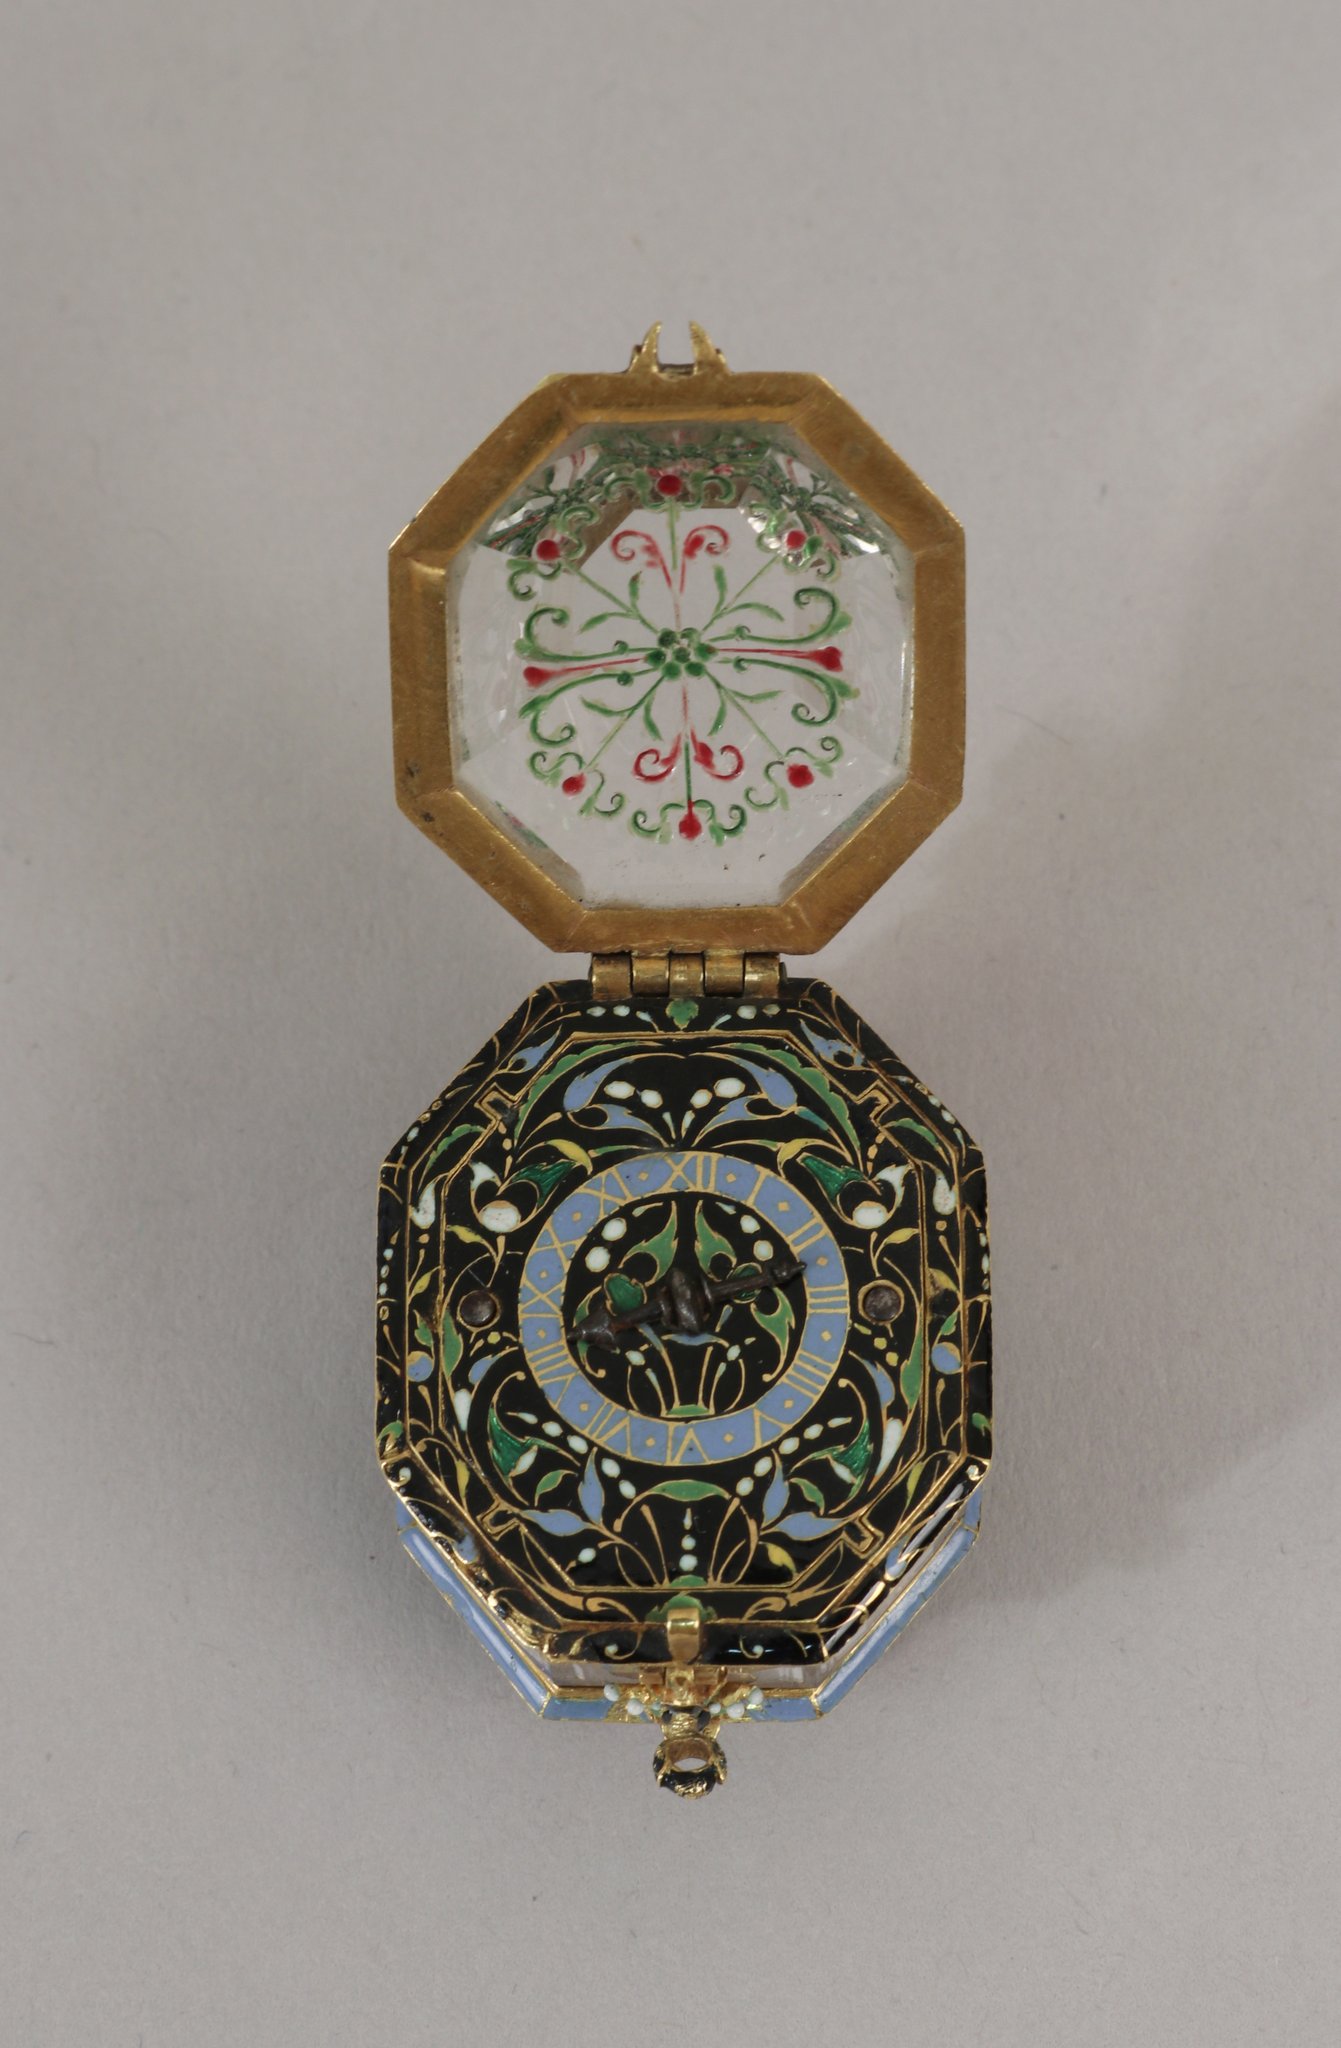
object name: watch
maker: pierre vernede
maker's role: maker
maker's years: 1580-1680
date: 1650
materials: enamel, gilt brass, gold, quartz, steel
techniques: enamel, painting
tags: leaves